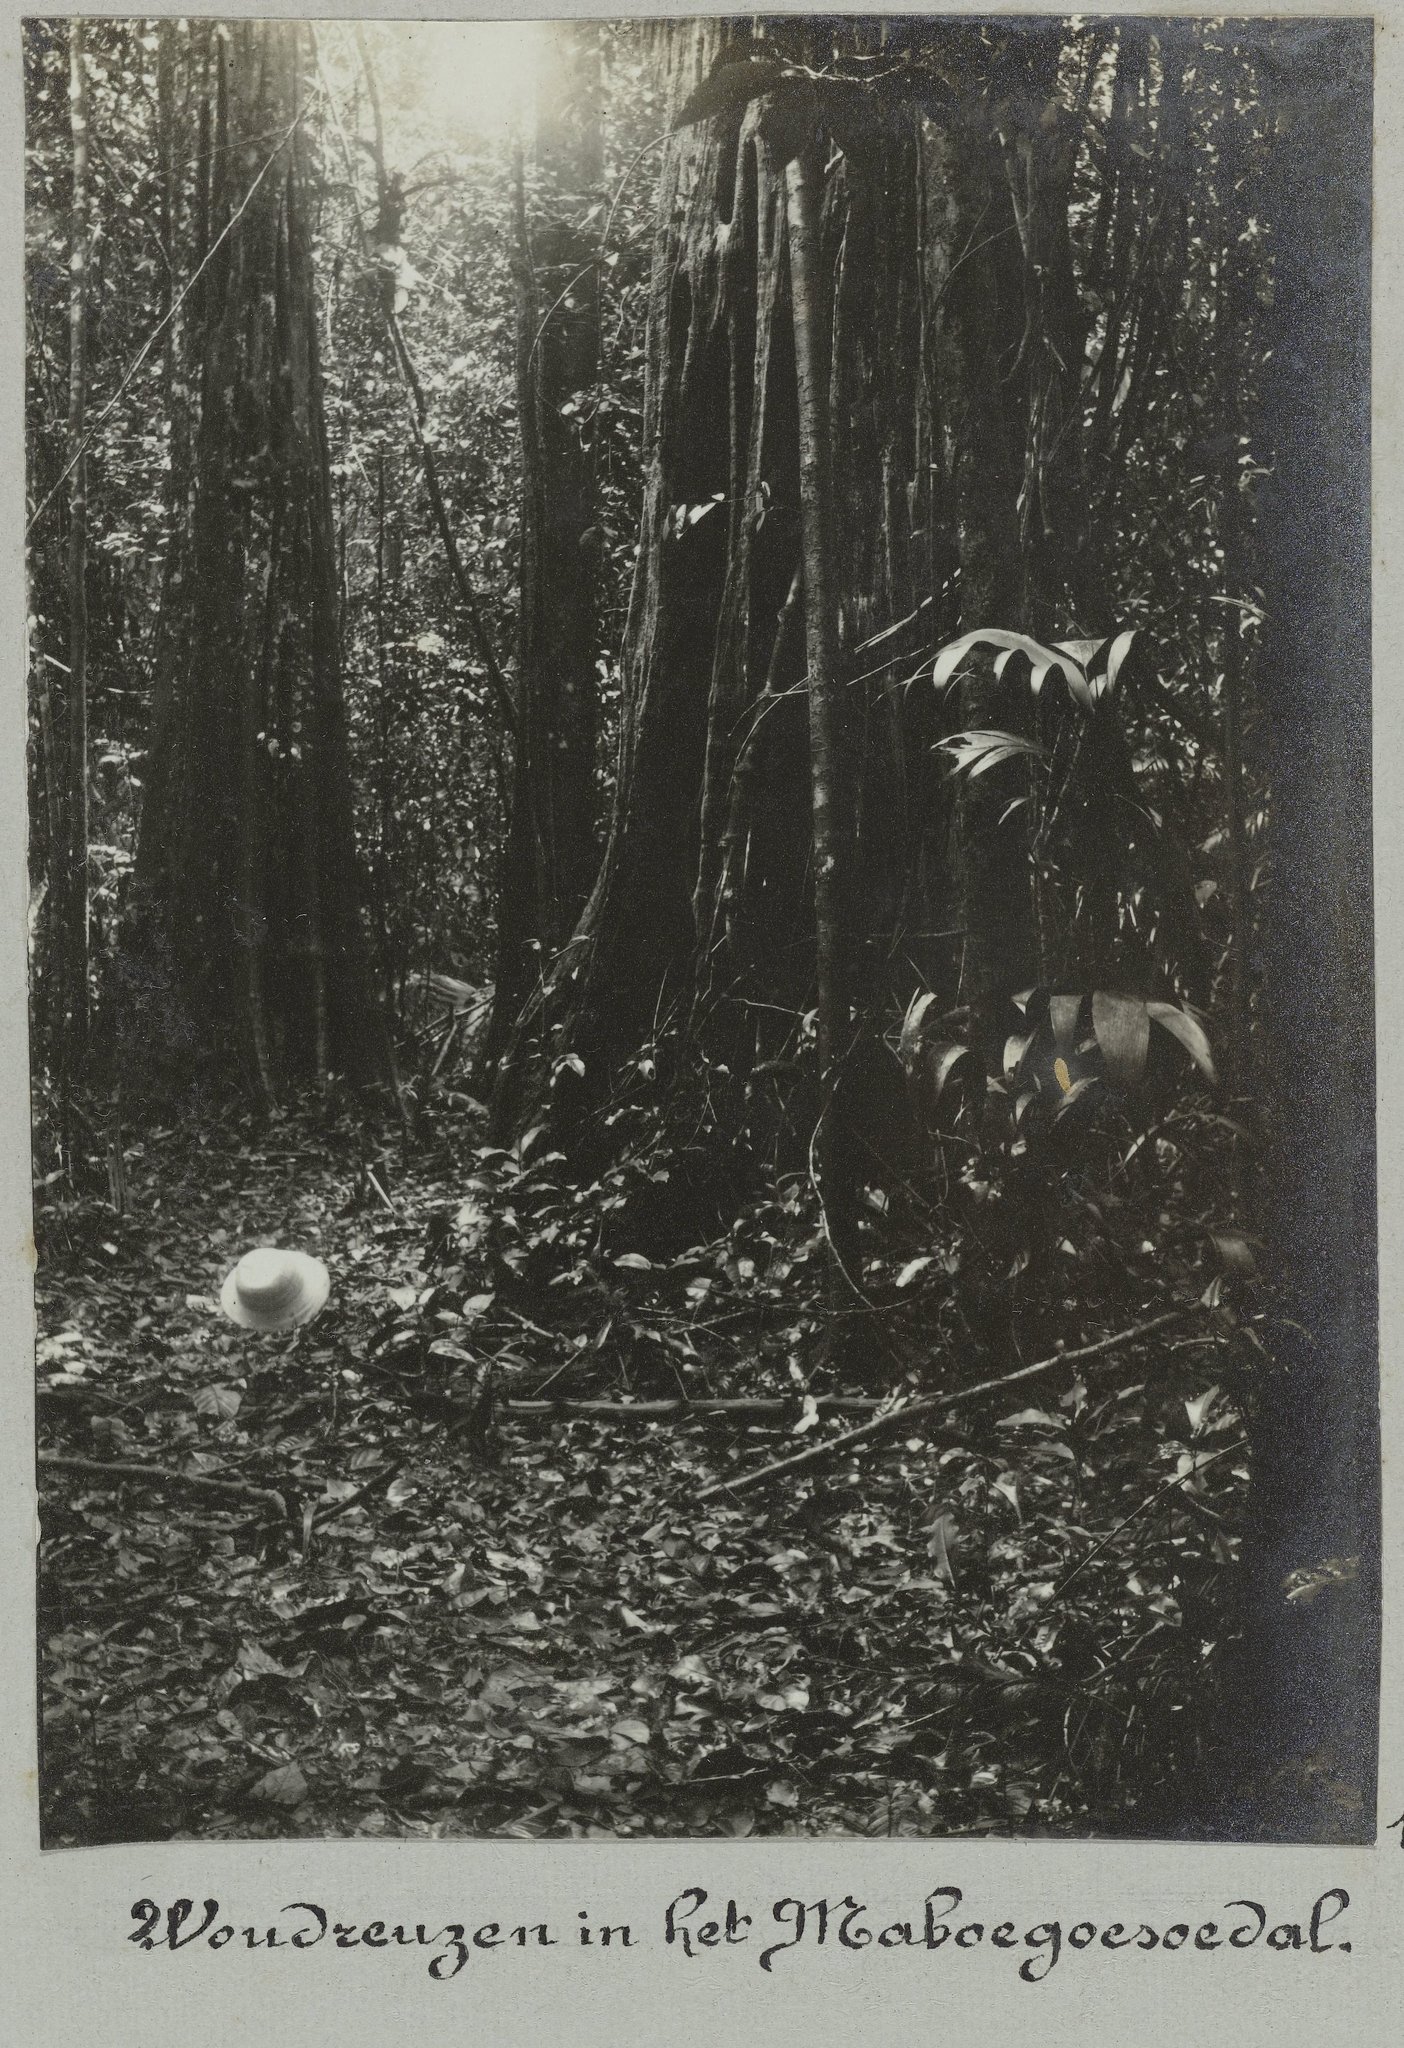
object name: photograph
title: Woudreuzen in het Maboegoesoedal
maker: hendrik doijer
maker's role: engineer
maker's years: 1863-1925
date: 1903-1910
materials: photographic support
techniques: gelatin silver print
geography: suriname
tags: suriname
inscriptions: inscription: ‘10. / Woudreuzen in het Maboegoesoedal.’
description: Grote bomen in het oerwoud in het Maboegoesoedal. Onderdeel van het fotoalbum Souvenir de Voyage (deel 1), over het leven van de familie Doijer in en rond de plantage Ma Retraite in Suriname in de jaren 1903-1910.